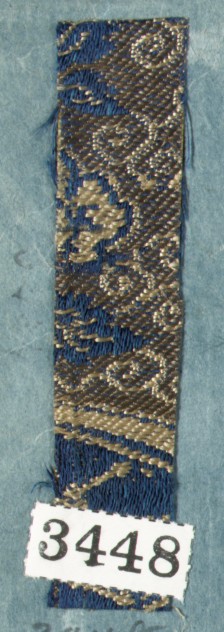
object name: sample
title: Textile Sample from Sample Book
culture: japanese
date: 1801-1900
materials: silk